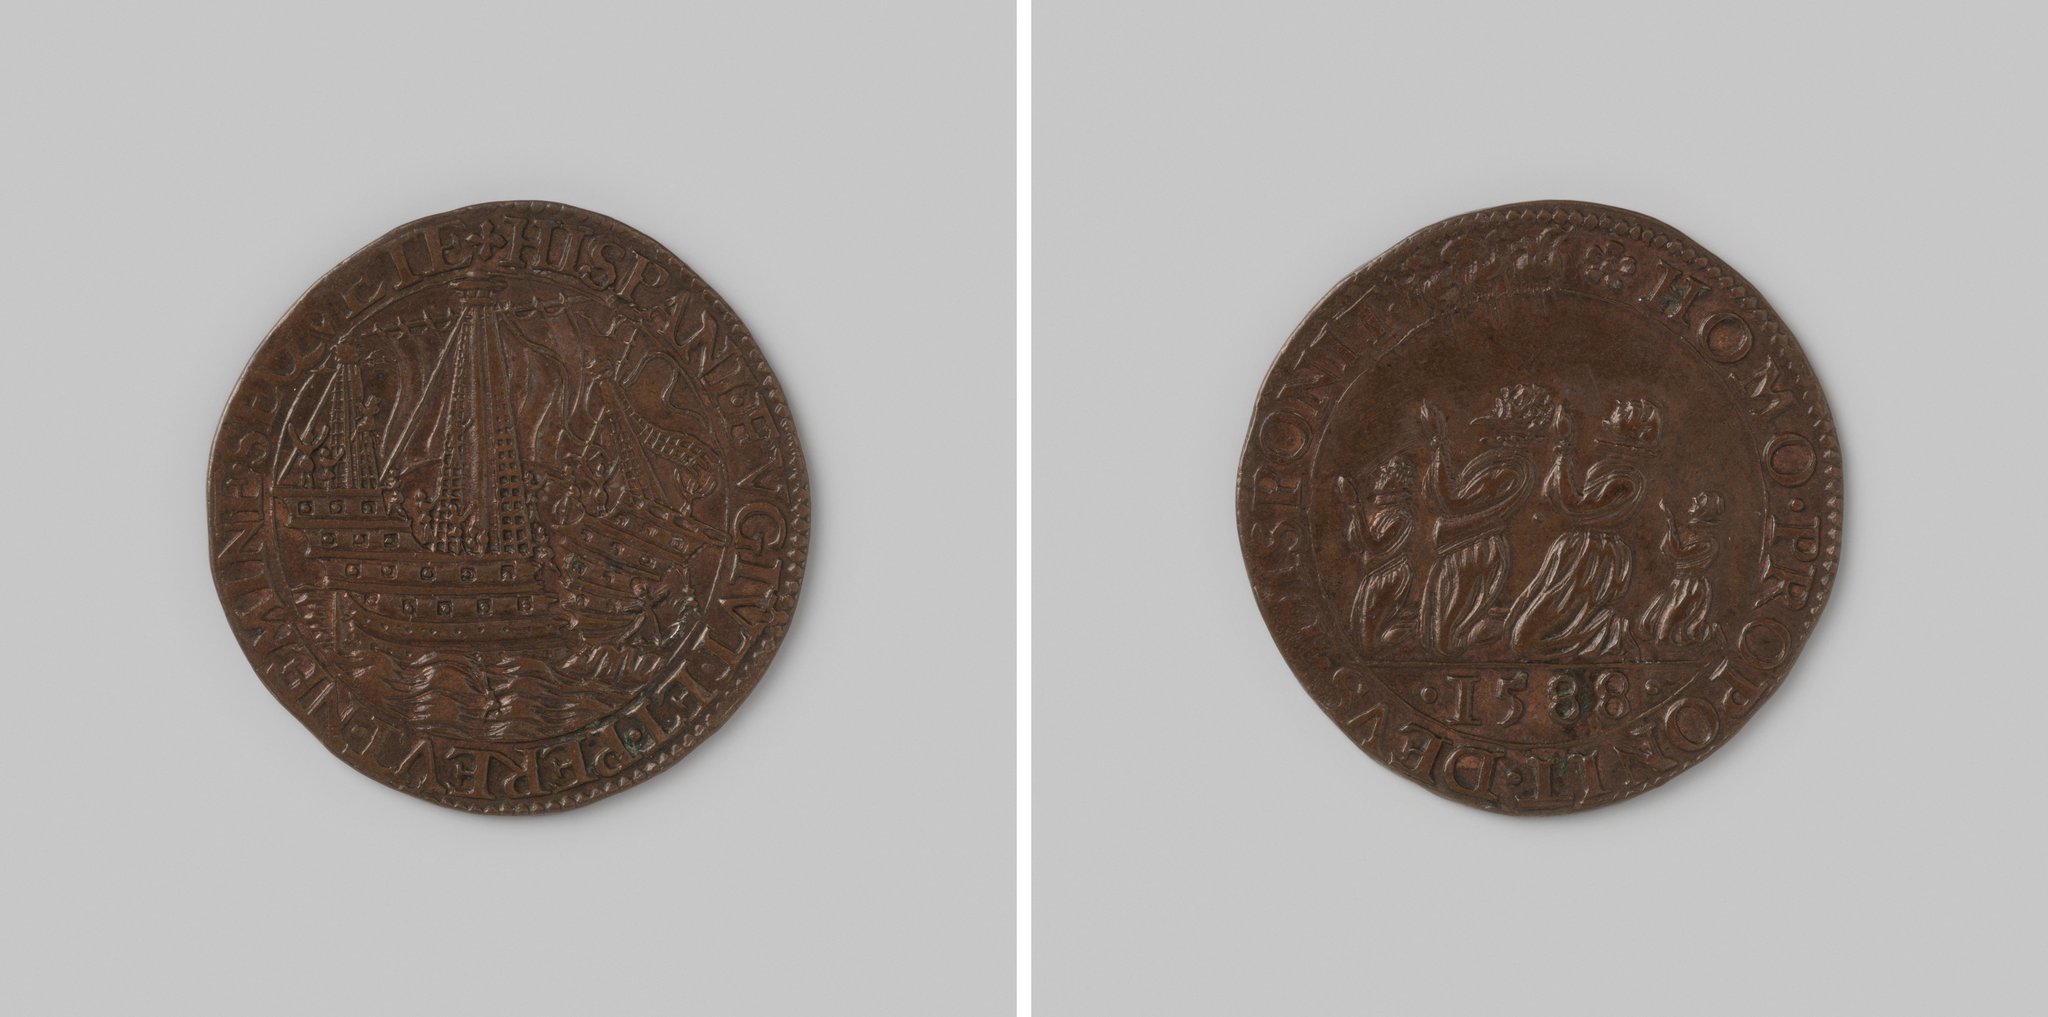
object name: history medal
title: Rekenpenning uit Dordrecht over de ondergang van de Onoverwinnelijke Spaanse Armada in 1588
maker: Anonymous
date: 1588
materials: copper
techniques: striking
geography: dordrecht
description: Koperen penning, op de voorzijde een verwoest oorlogsschip met omschrift, op de keerzijde vier biddende figuren naar links met afsnedetekst en omschrift.